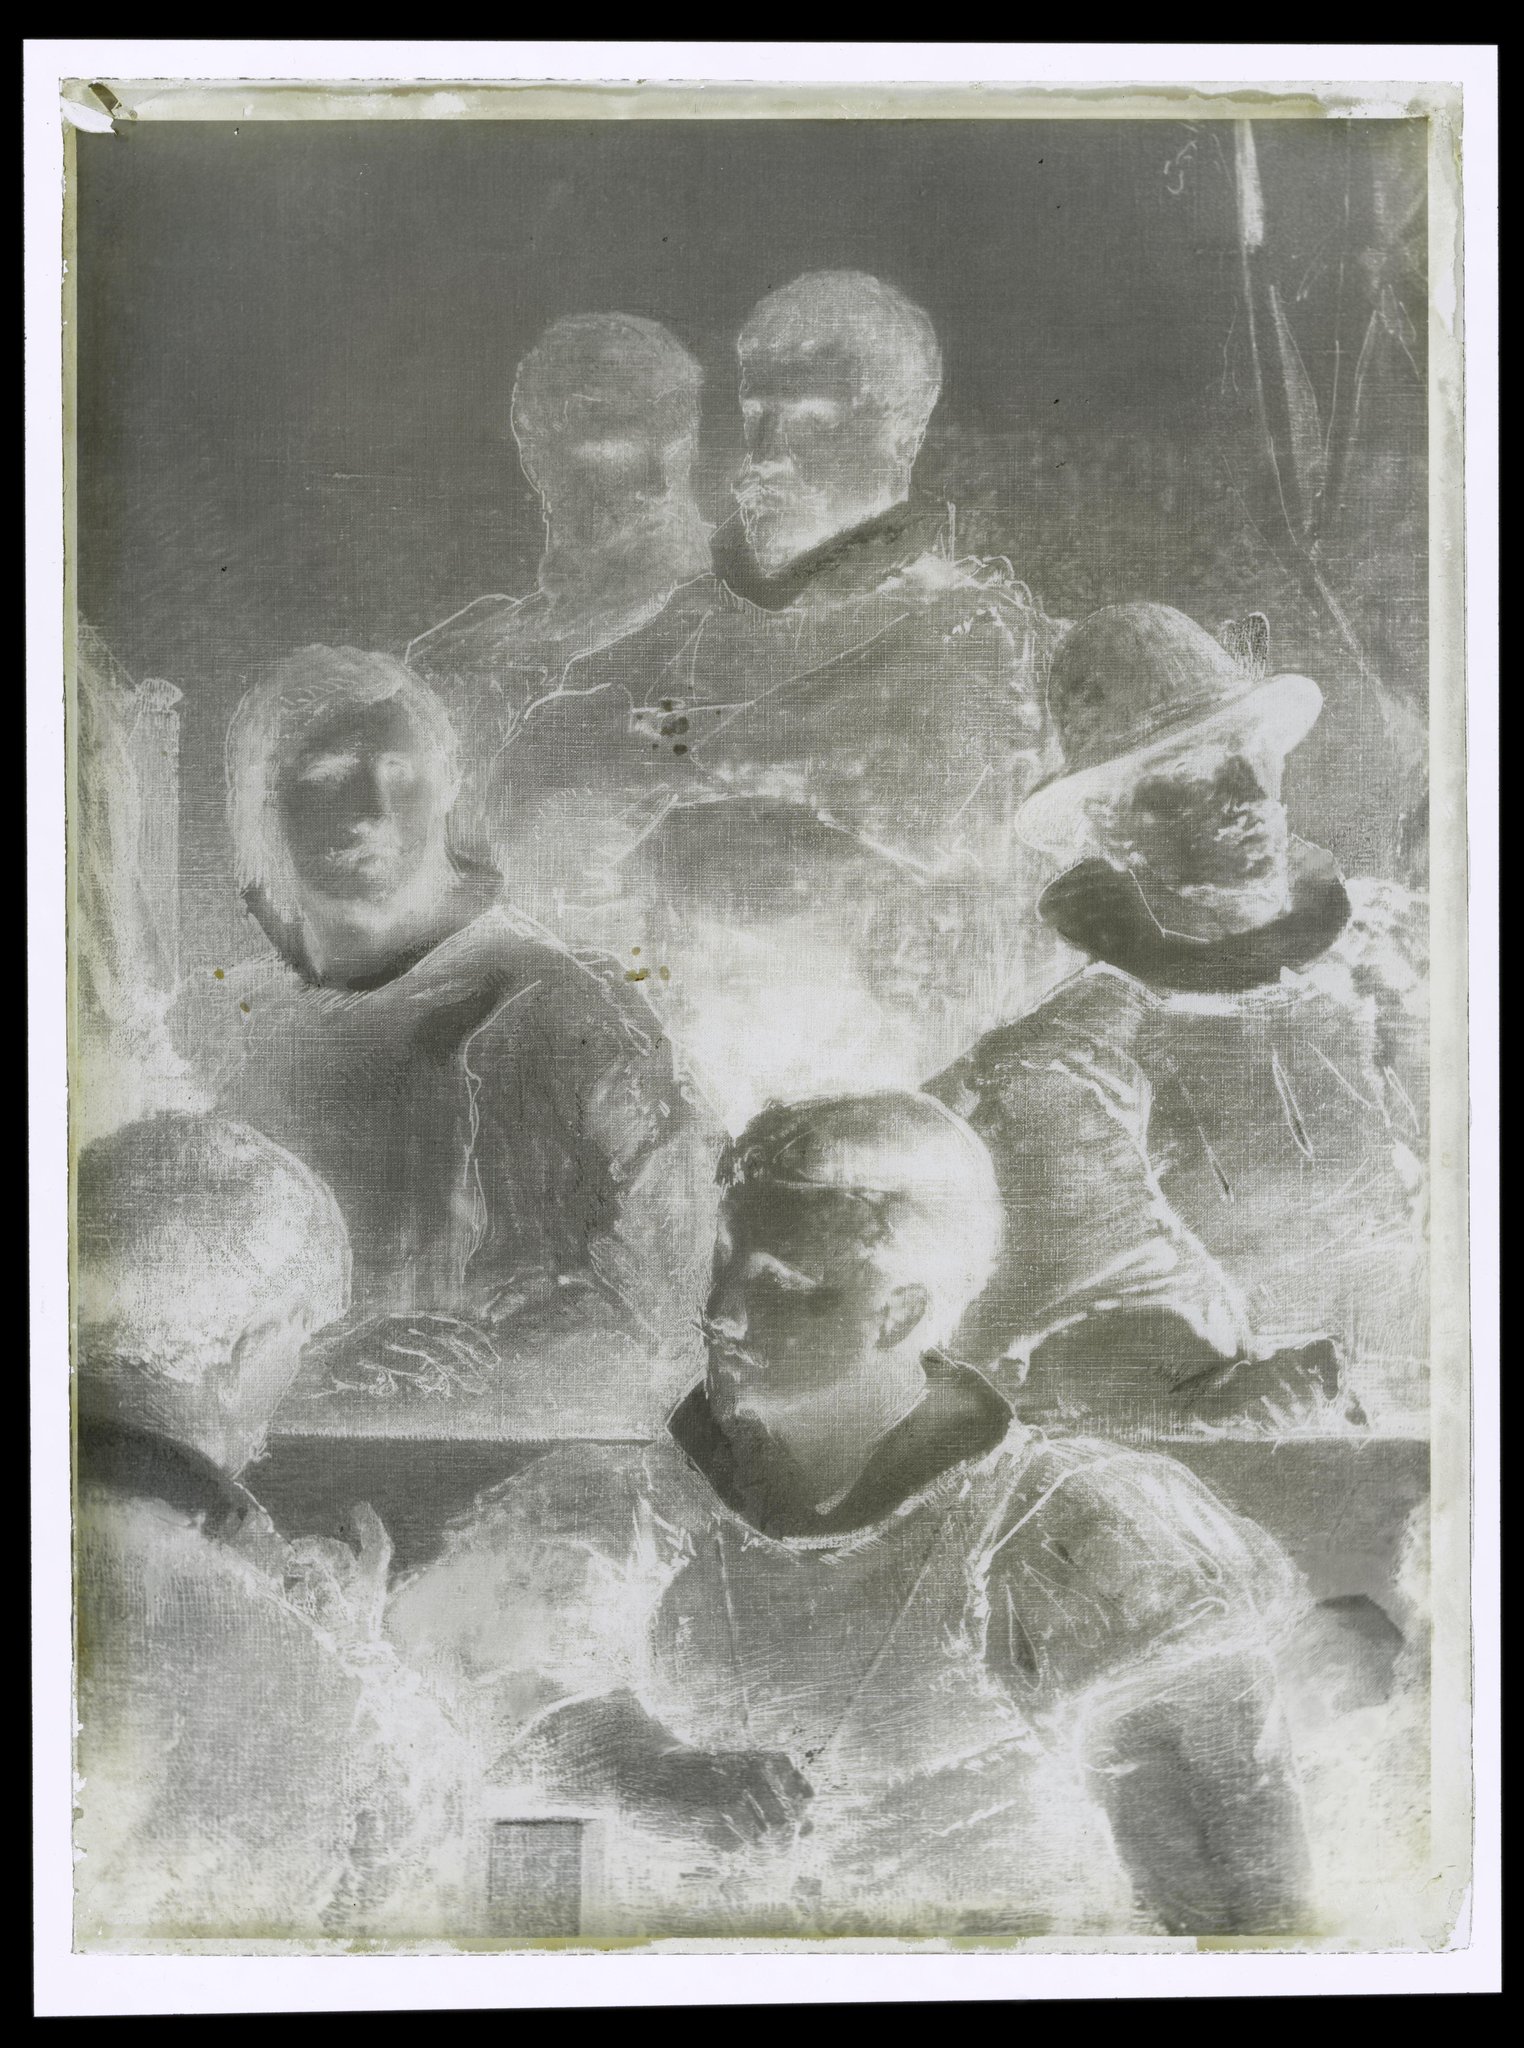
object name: glasnegatief, glasplaatnegatief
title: Fotoreproductie van een detail van een schilderij met een scène uit het leven van Willem van Oranje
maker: laurens lodewijk kleijn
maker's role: draughtsman, painter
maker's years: 1826-1909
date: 1865-1900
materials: glass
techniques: collodion process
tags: delft, william i (prince of orange), prince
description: Onderdeel van een groep glasnegatieven uit de nalatenschap van de schilder Laurens Lodewijk Kleijn, met stillevens, portretten, zelfportretten en kunstreproducties.